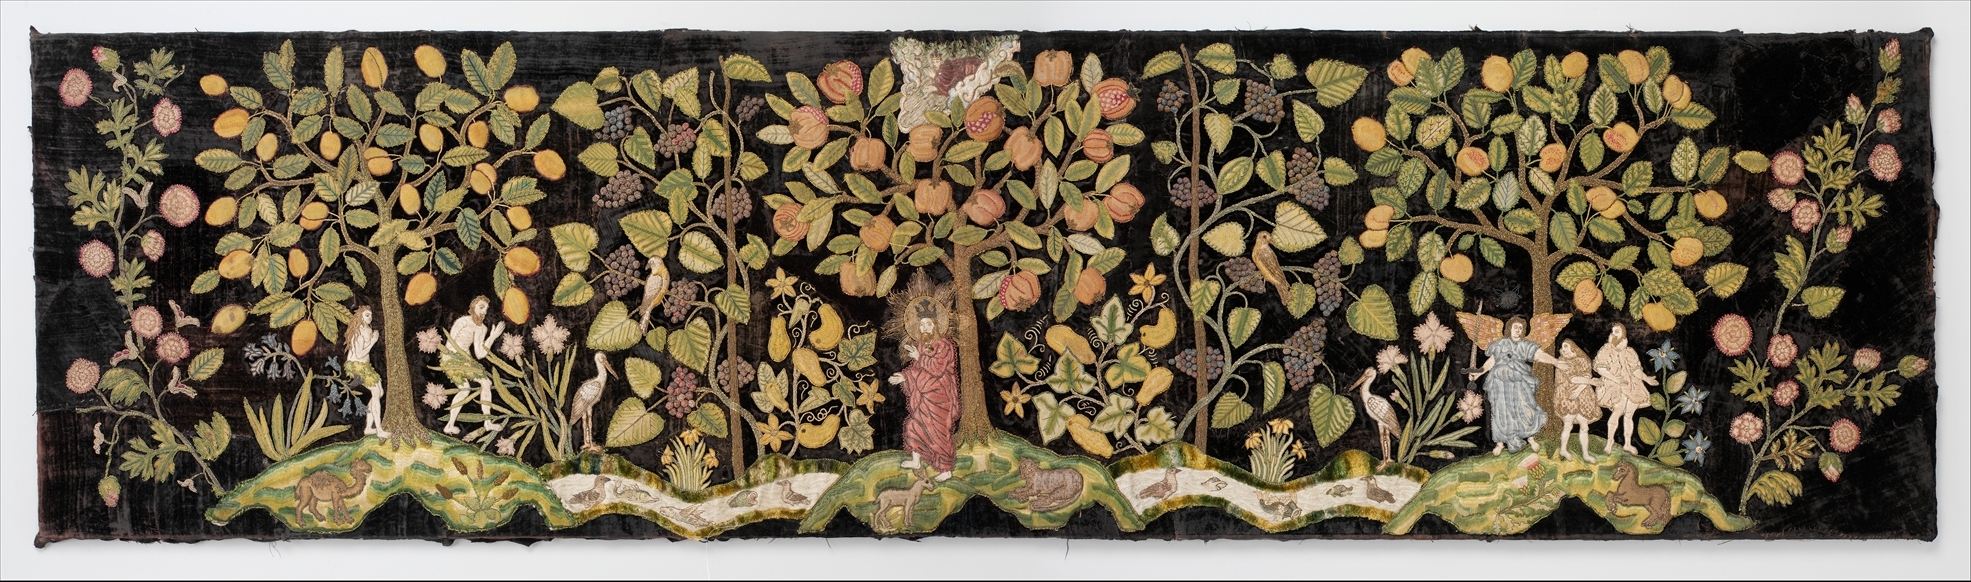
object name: panel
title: The Garden of Eden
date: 1576-1600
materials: canvas, metal thread, textile, silk, thread, velvet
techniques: embroidery, stitching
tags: birds,gardens,trees,angels,adam,eve